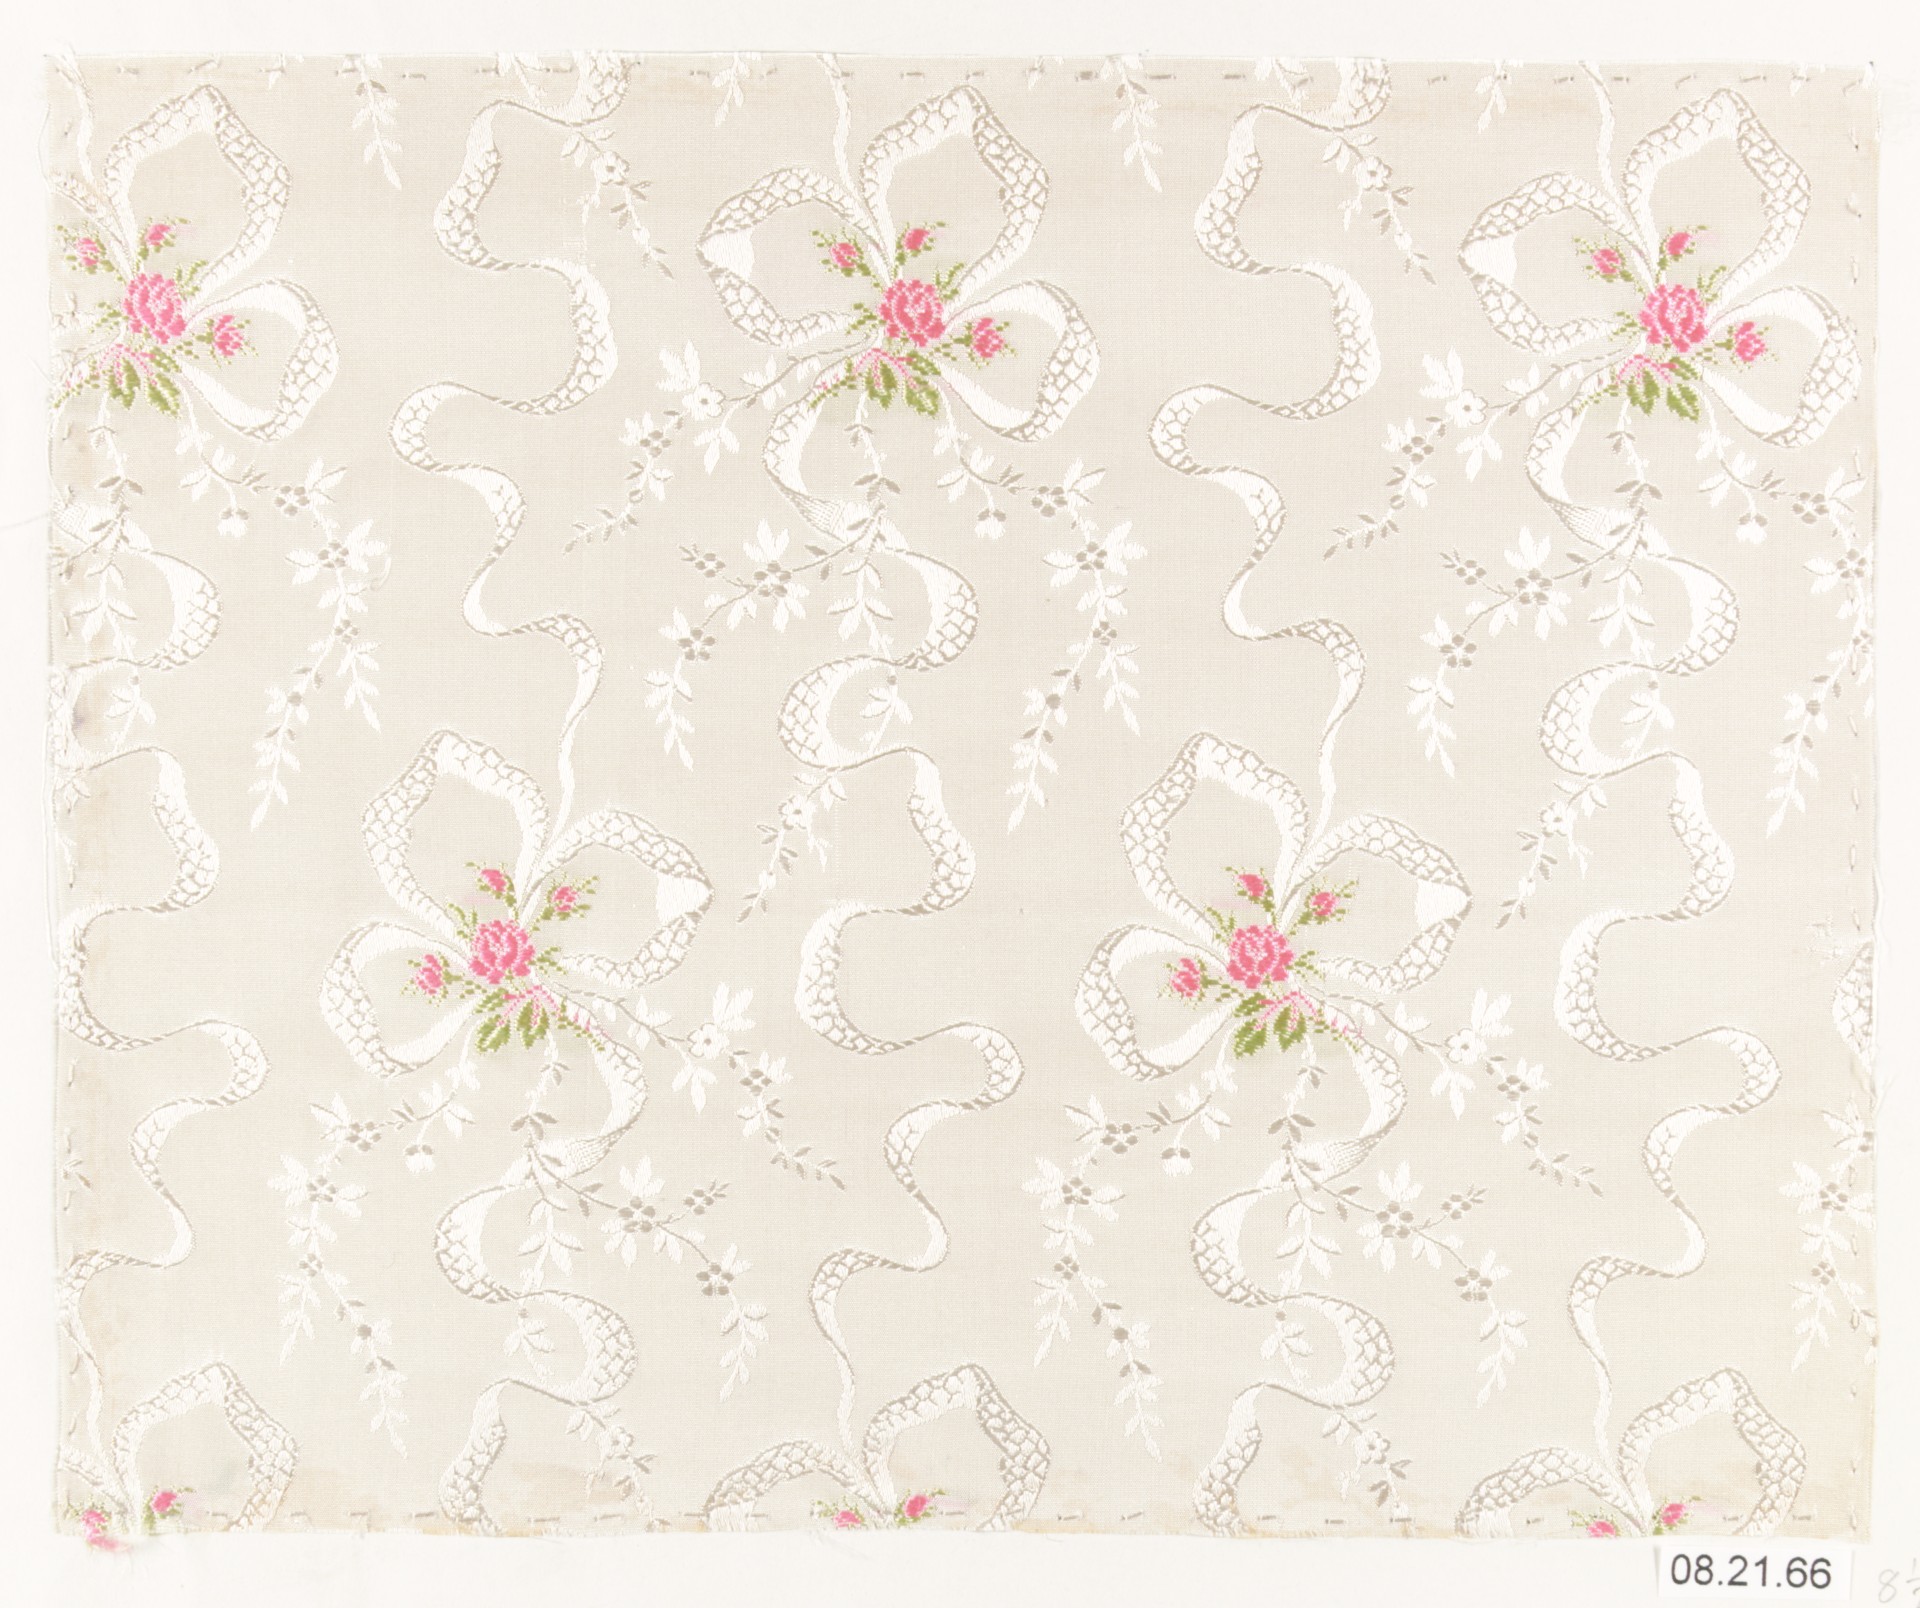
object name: textile sample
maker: Anonymous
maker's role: designer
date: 1900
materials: silk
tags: flowers